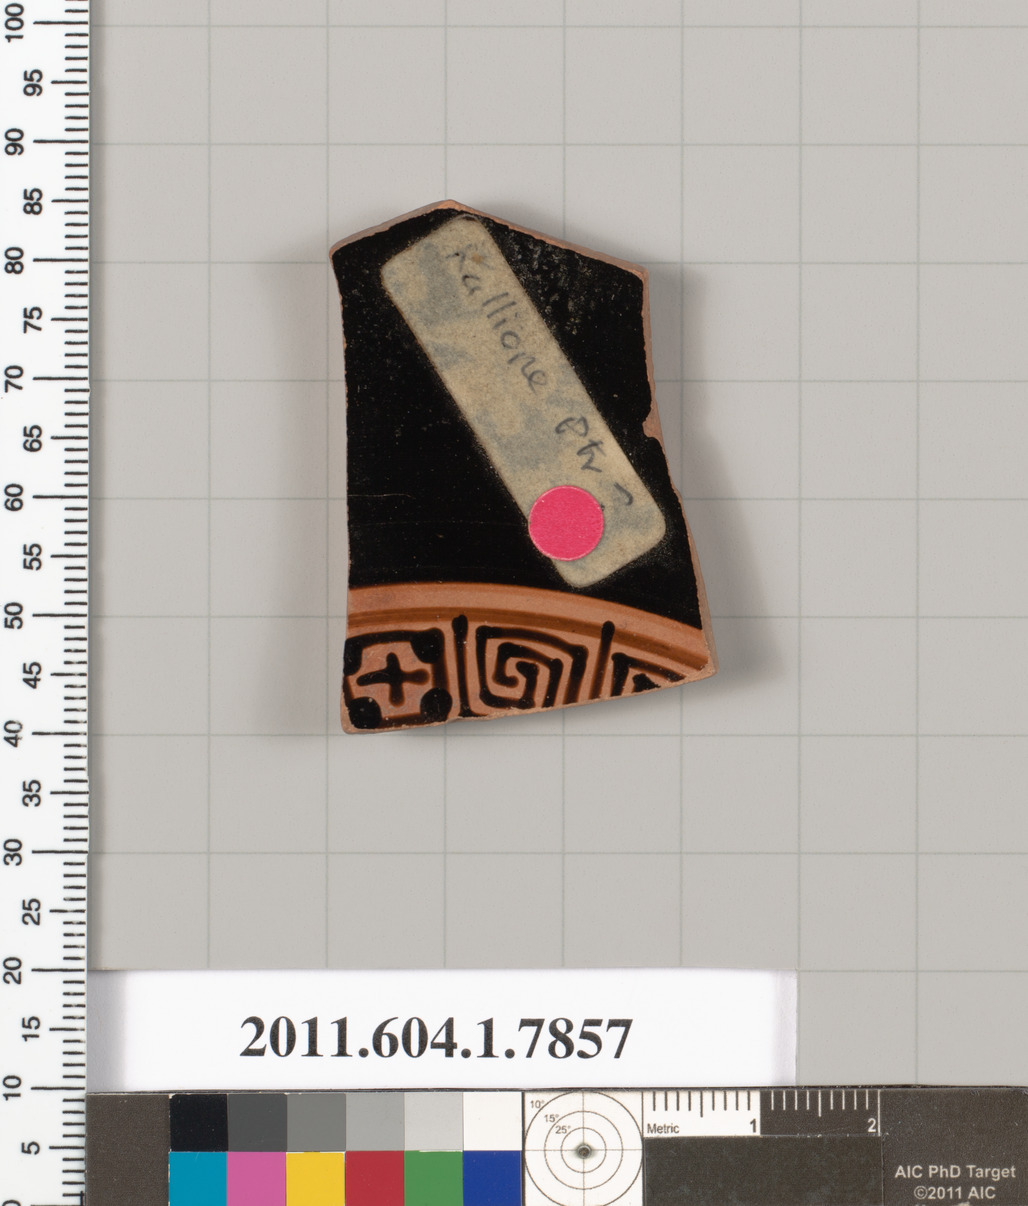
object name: kylix fragment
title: Terracotta fragment of a kylix (drinking cup)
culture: greek, attic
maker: calliope painter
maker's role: artist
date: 440-420 BCE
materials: terracotta